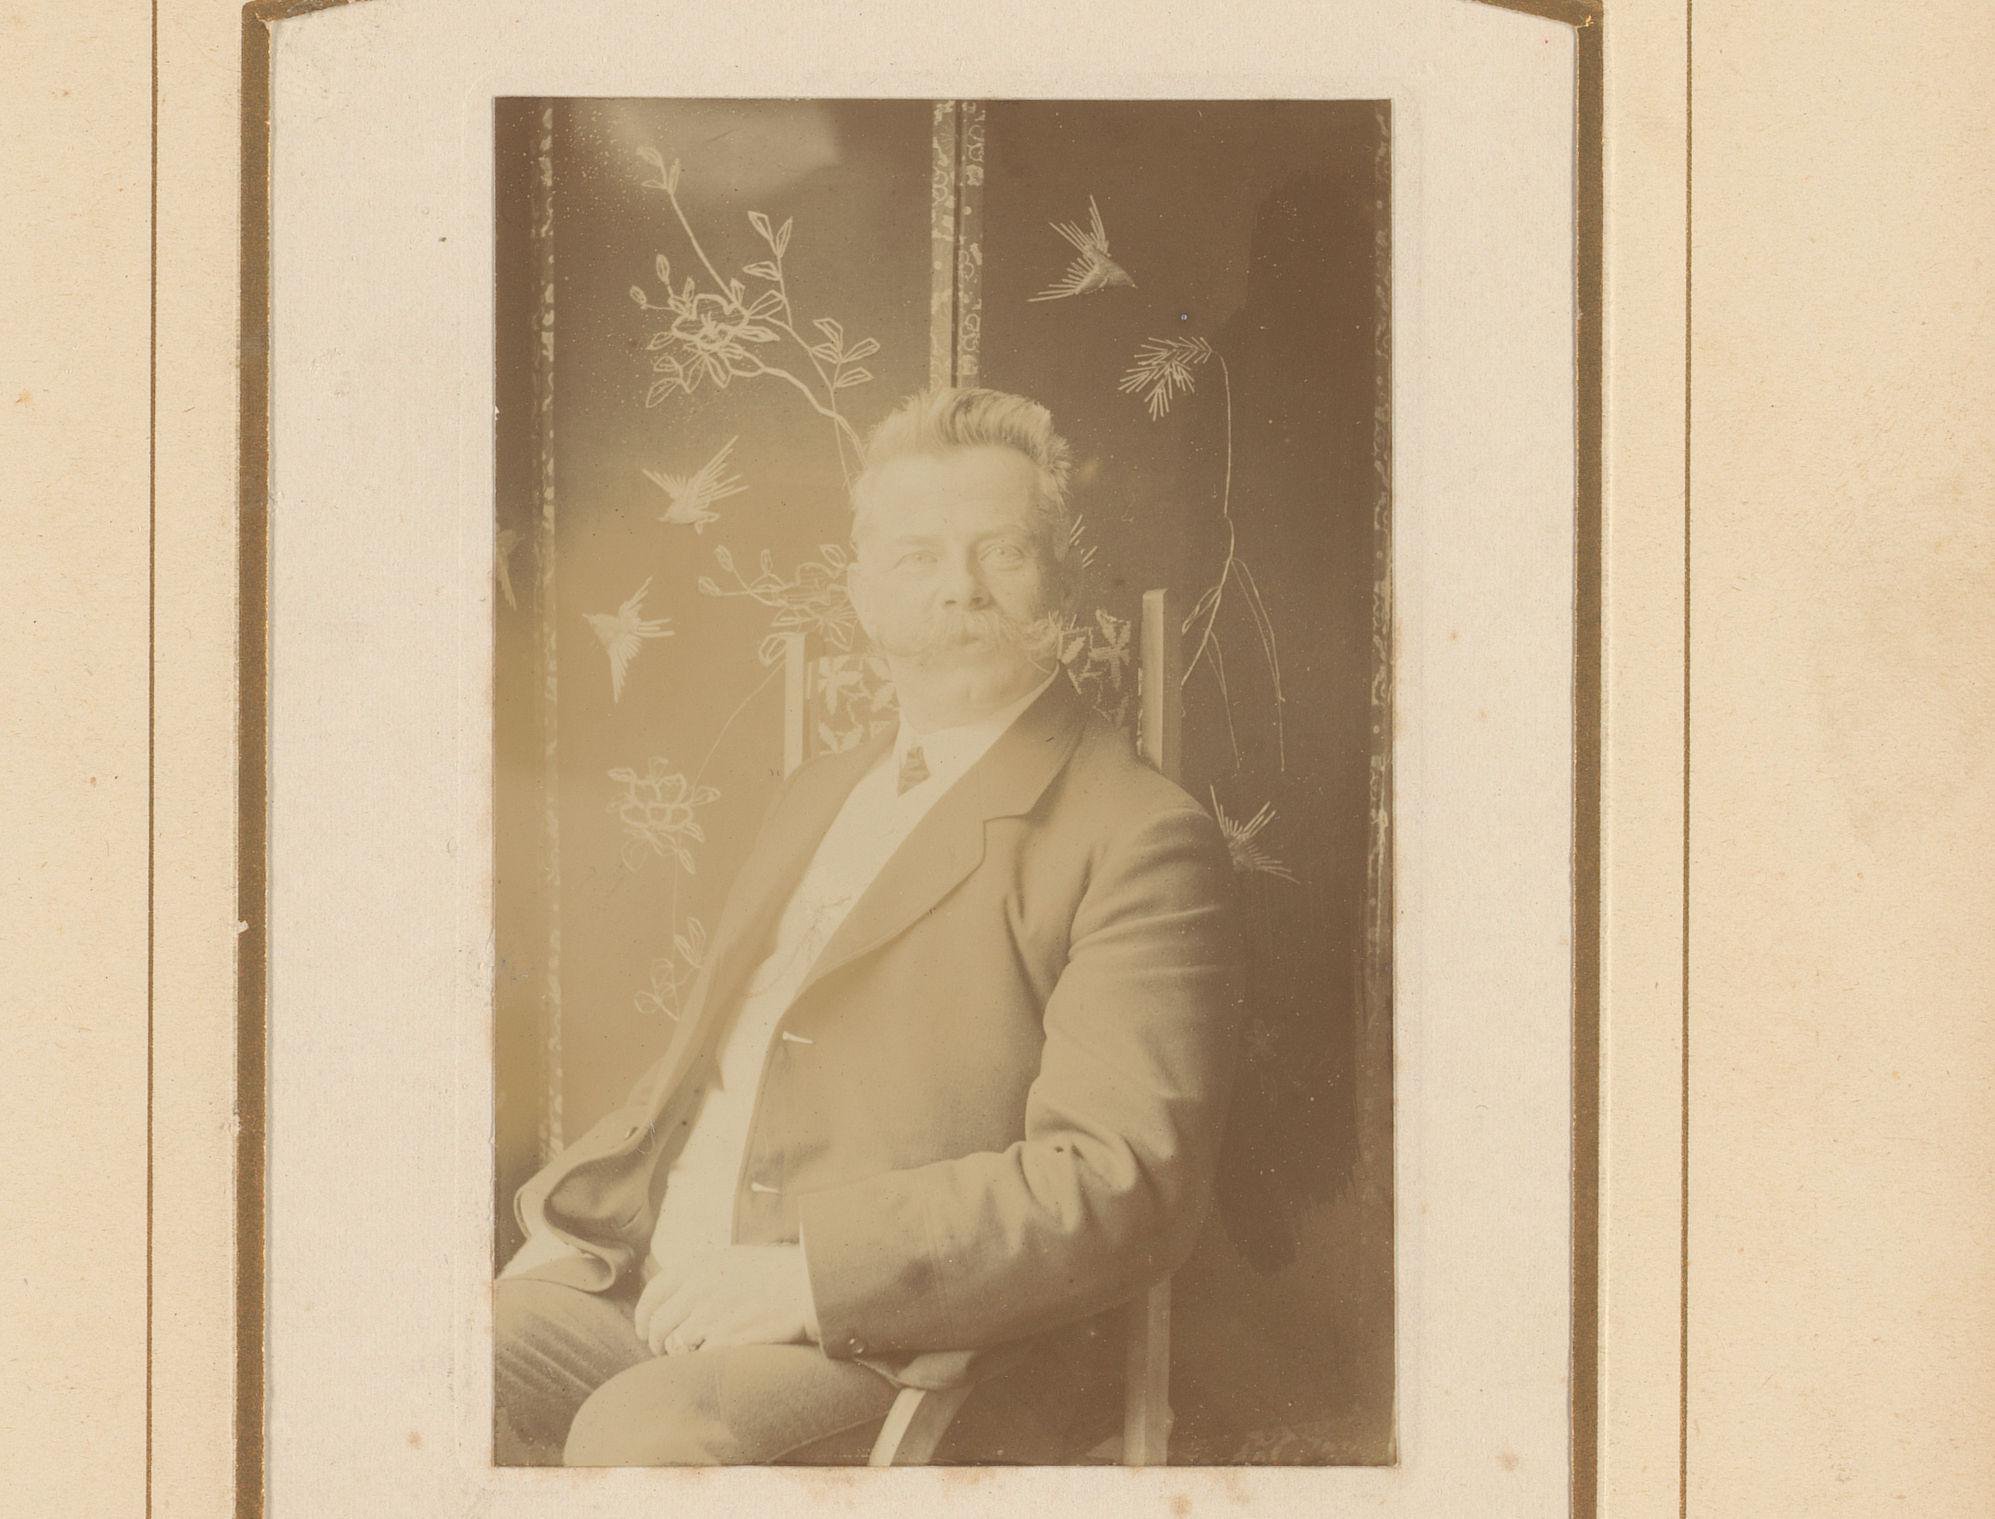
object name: album leaf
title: Portret van een man, zittend voor een kamerscherm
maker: Anonymous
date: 1900-1920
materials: cardboard, photographic support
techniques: collodion silver print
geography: netherlands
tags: sitting figure, historical persons, screen, folding screen